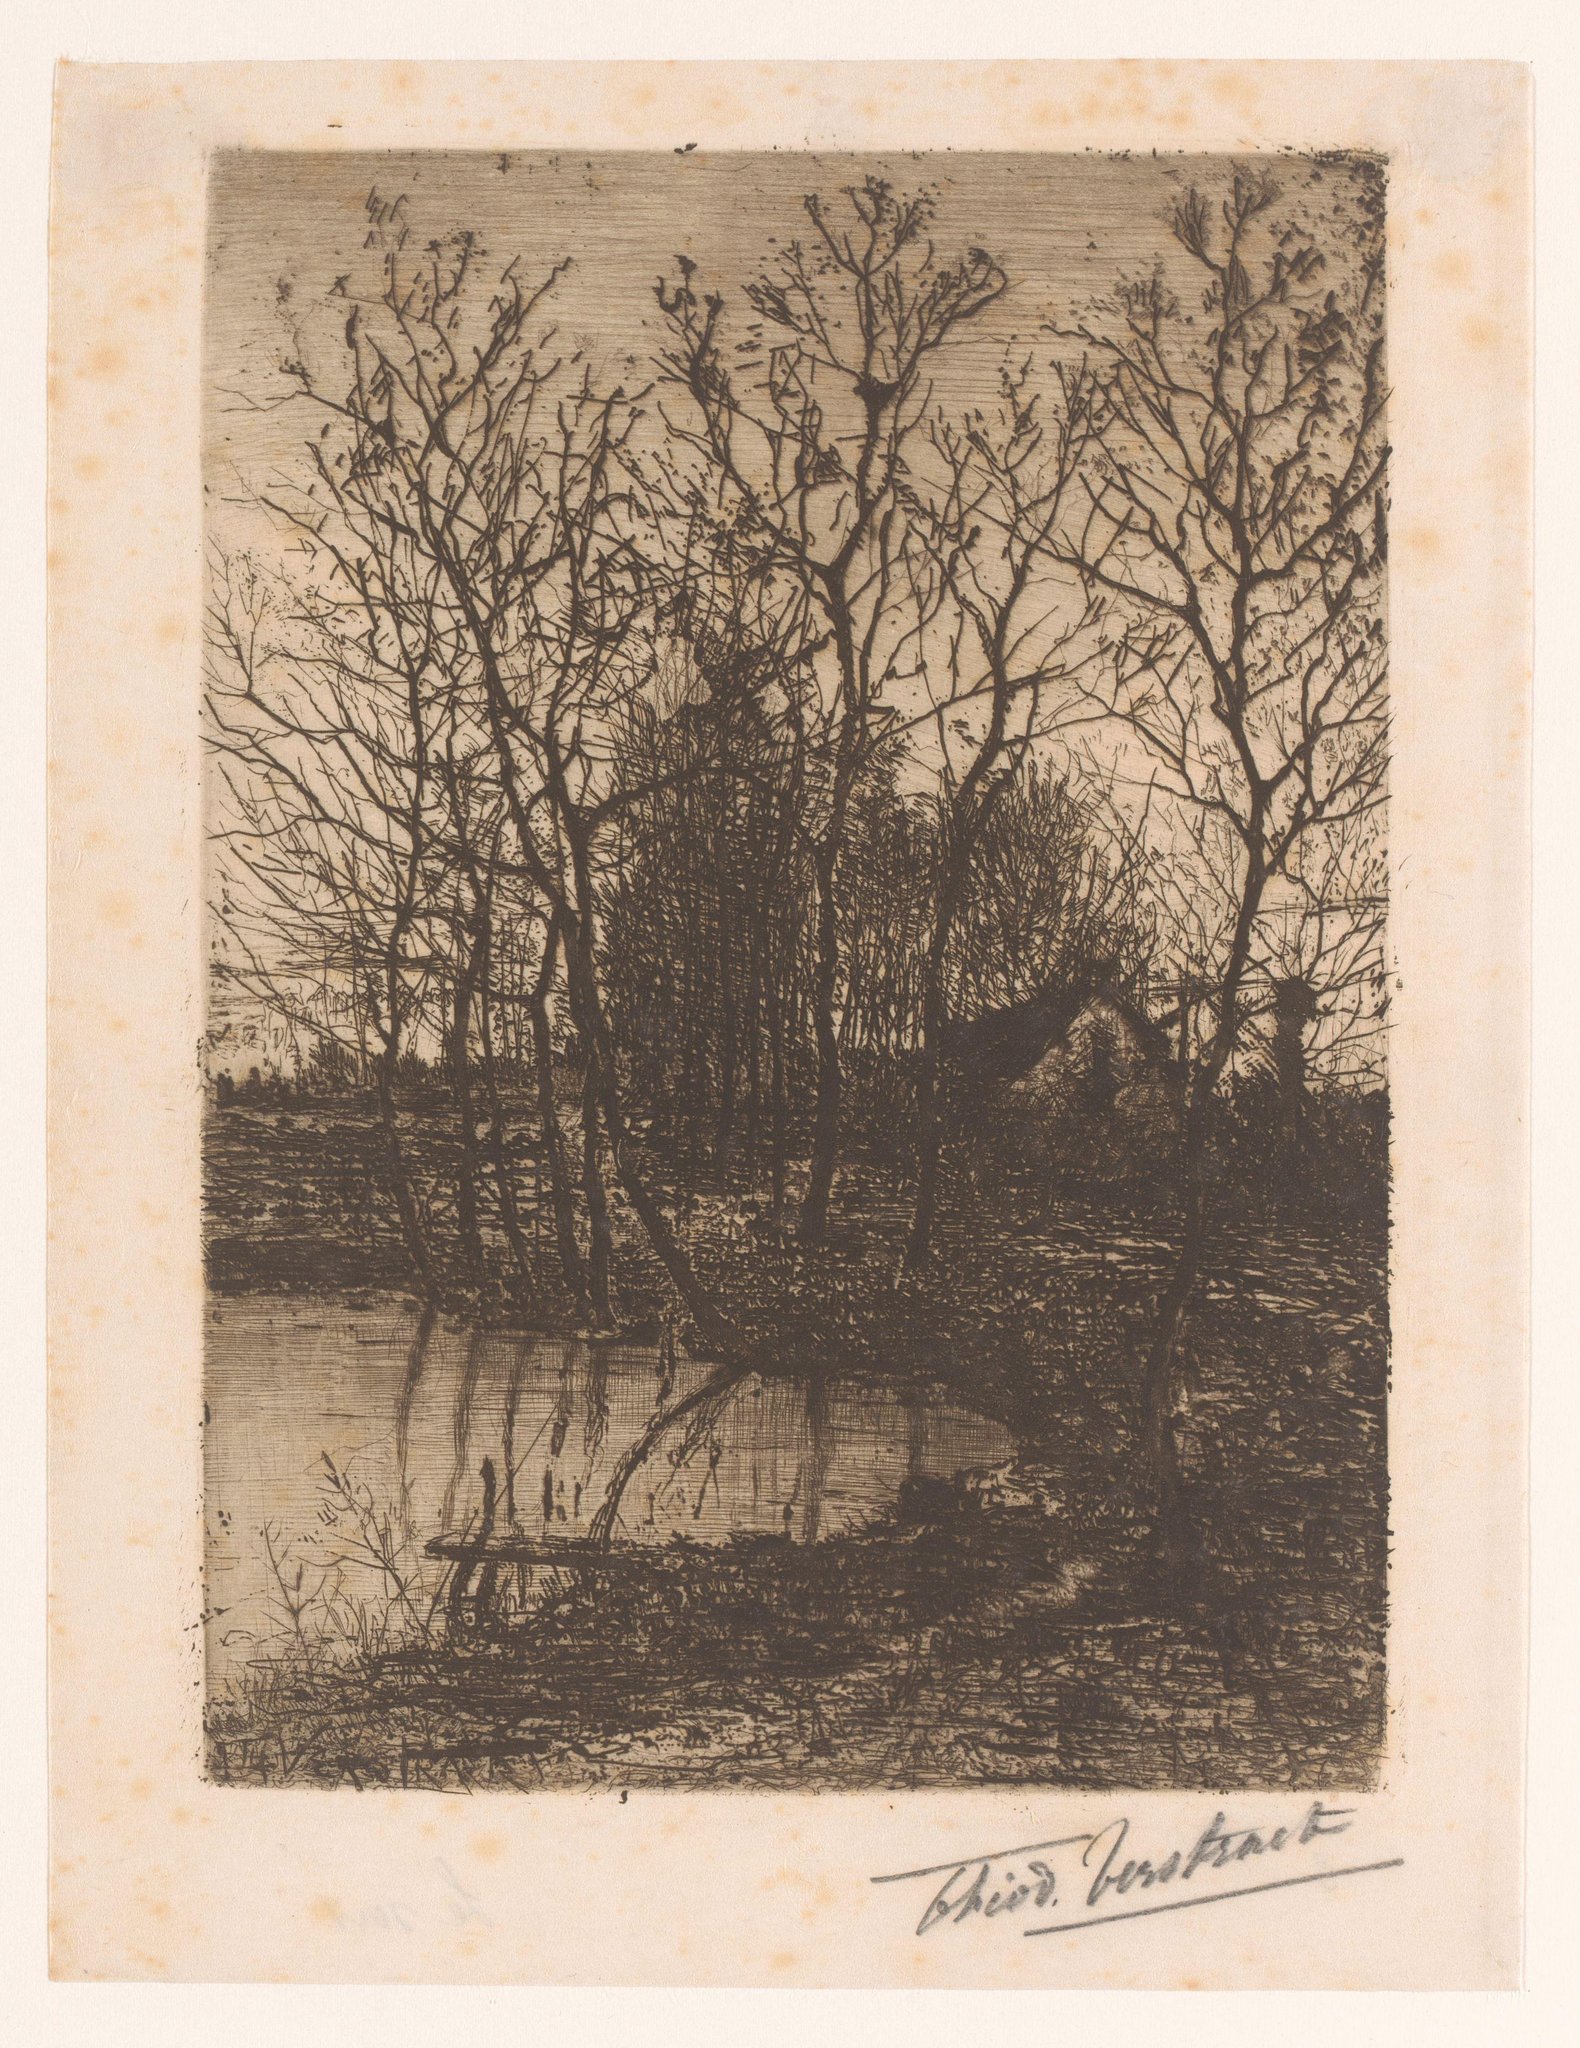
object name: print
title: Landscape at Night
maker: theodoor verstraete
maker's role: painter, print maker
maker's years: 1850-1907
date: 1880-1907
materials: paper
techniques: drypoint, etching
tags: landscapes, night ~ landscape (sometimes titled 'nox')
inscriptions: collector's mark: Lugt 2228